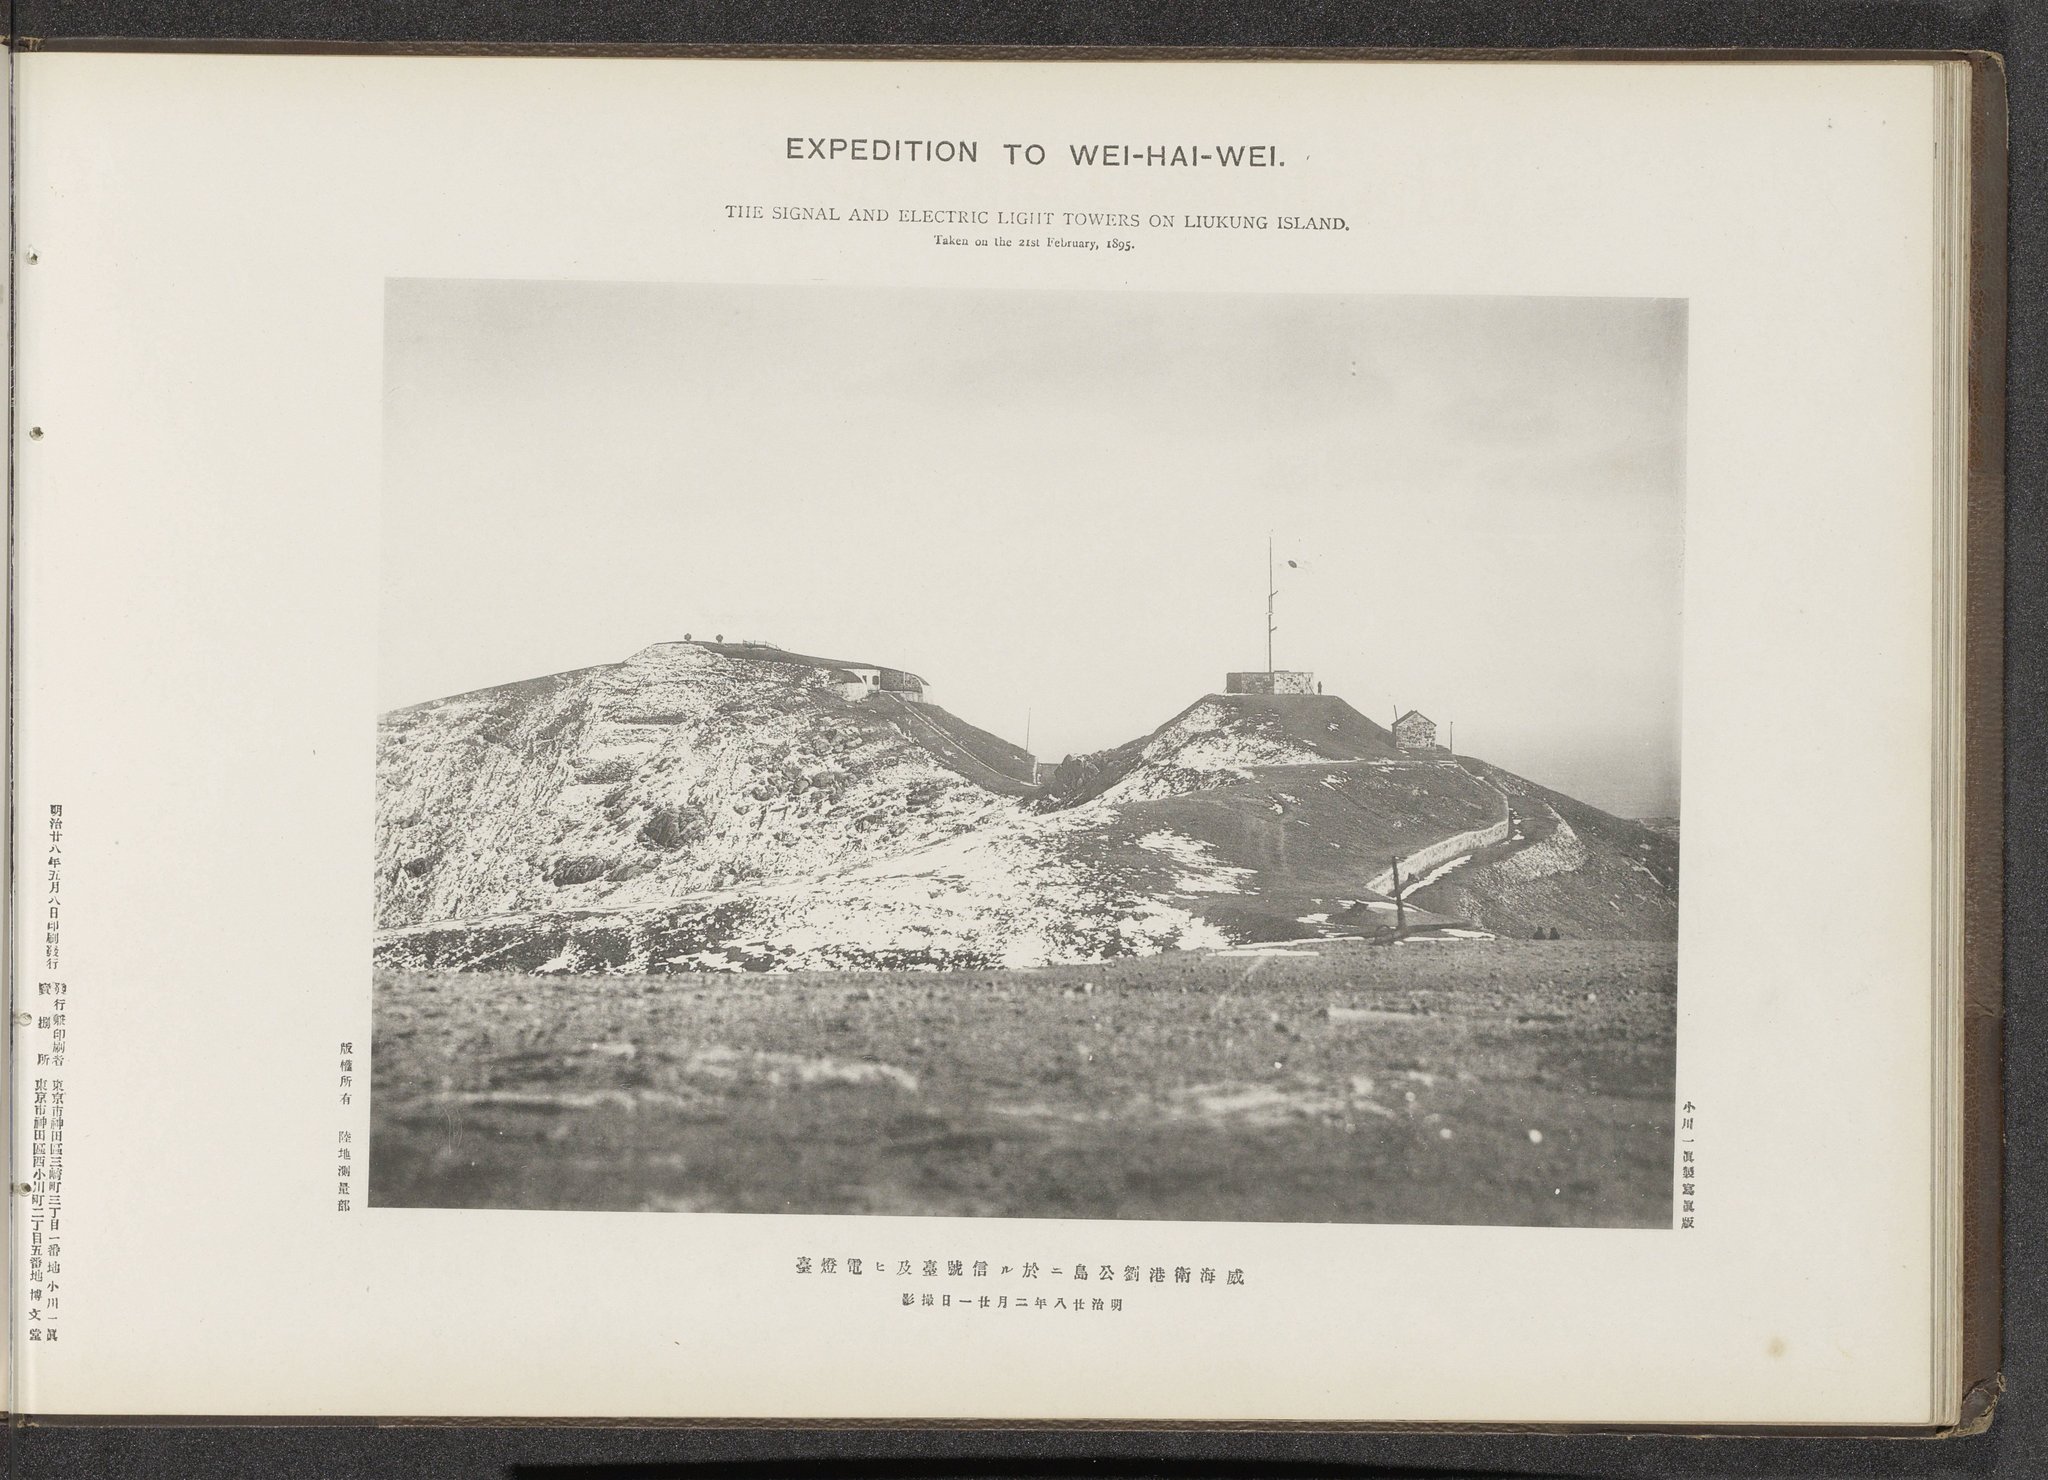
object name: page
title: The signal and electric light towers on Liukung Island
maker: kazumasa ogawa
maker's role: auteur, fotograaf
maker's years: 1860-1929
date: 1895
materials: paper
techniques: photograph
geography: japan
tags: island, low hill country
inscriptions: inscription: ‘Expedition to Wei-Hai-Wei.’